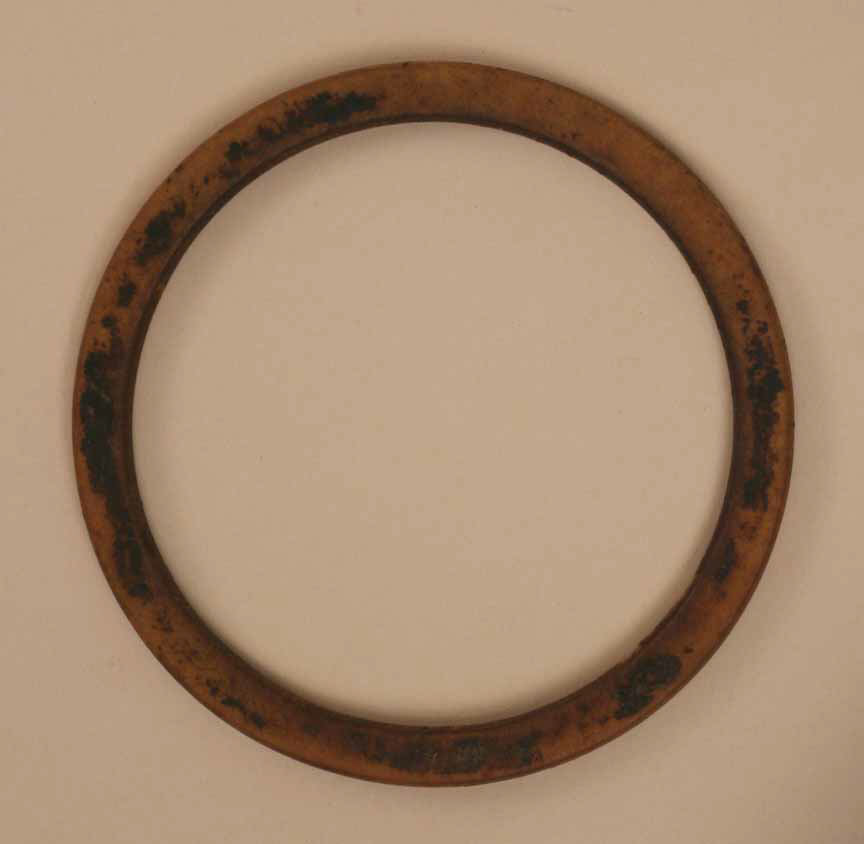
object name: bracelet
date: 201-1200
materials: ivory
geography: egypt